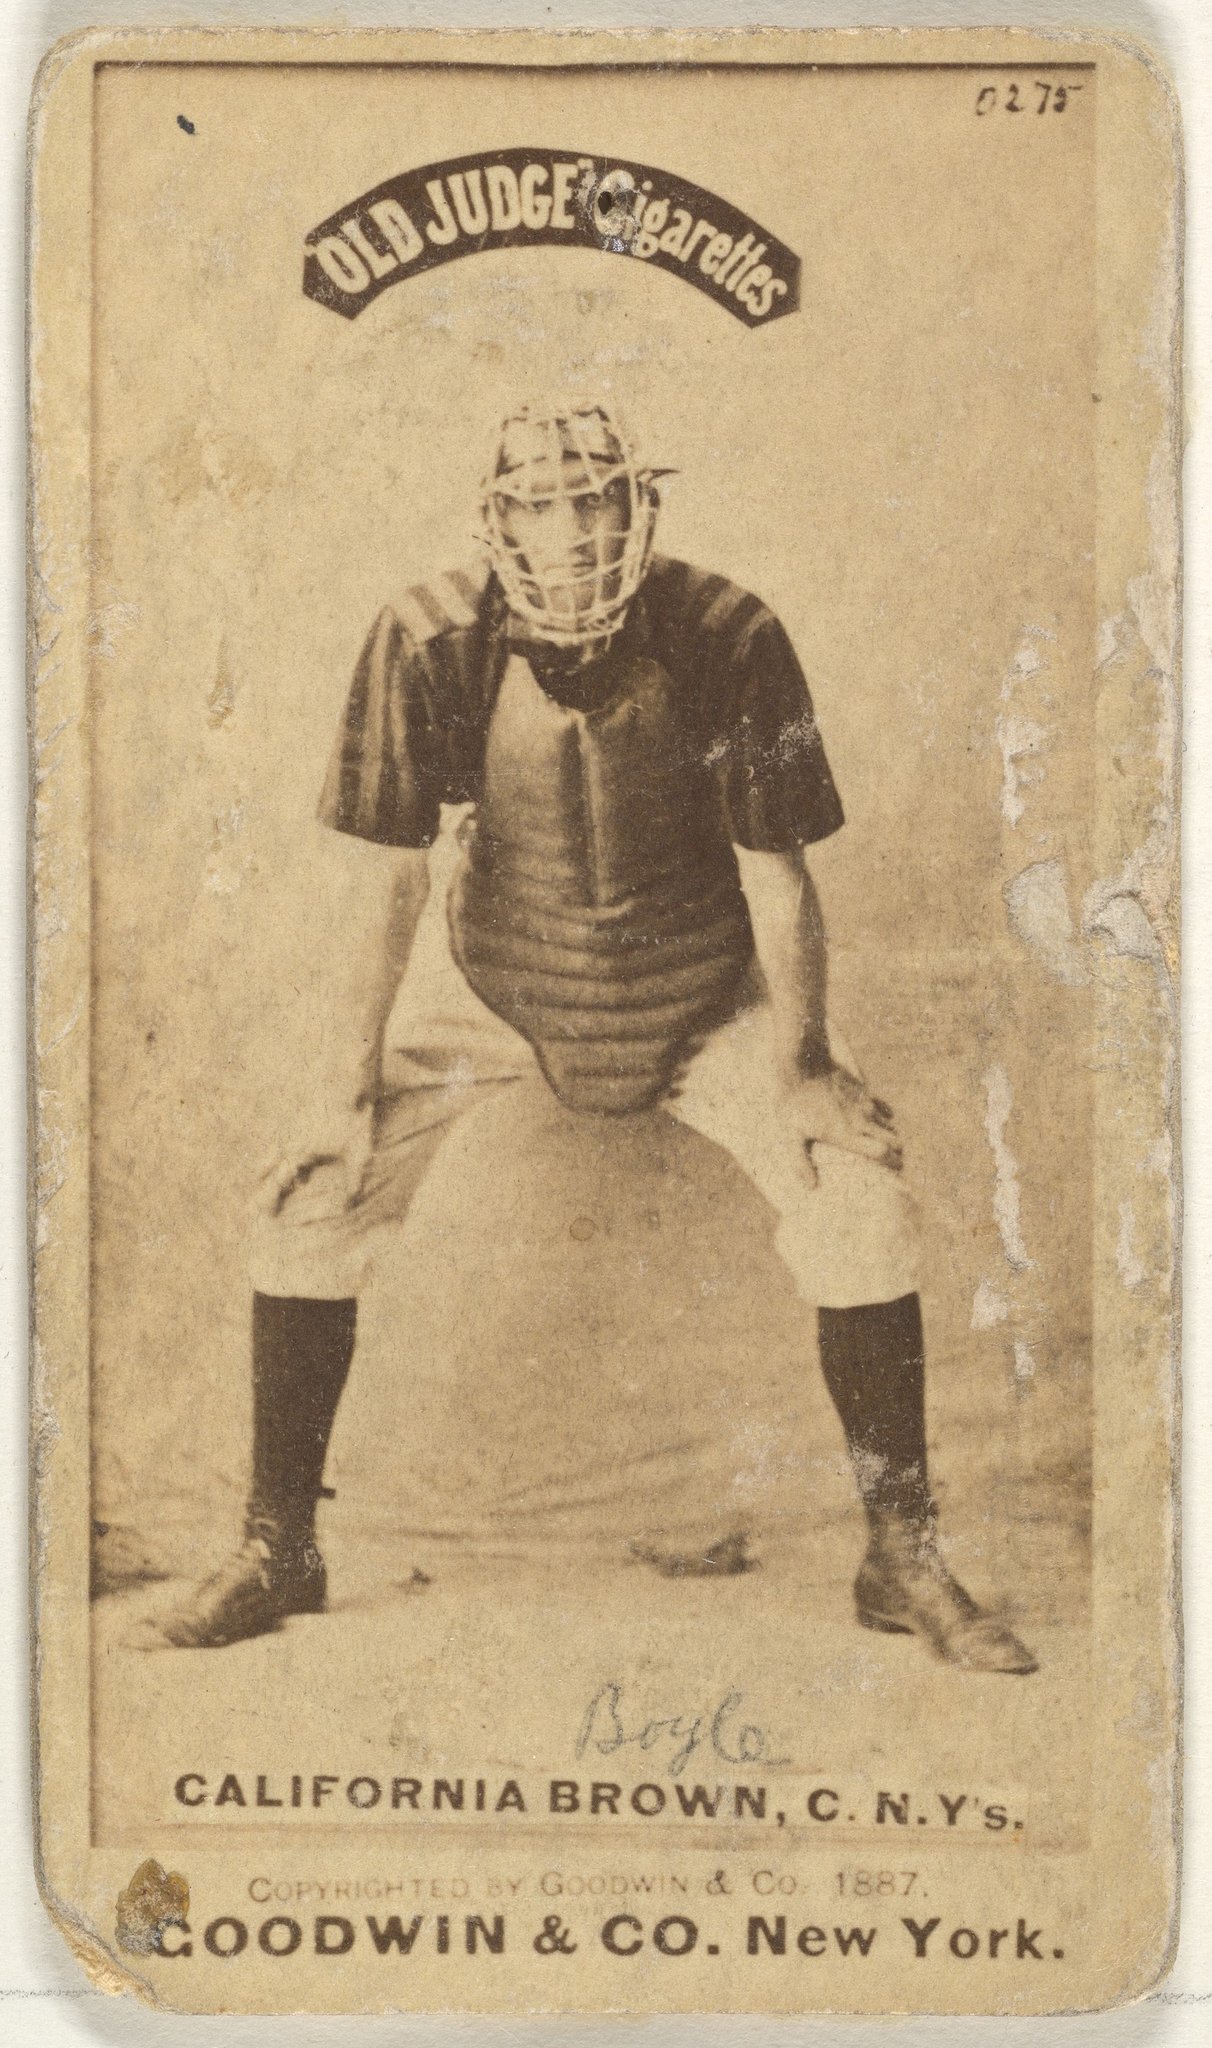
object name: baseball card, photograph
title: William "California" Brown, Catcher, New York, from the Old Judge series (N172) for Old Judge Cigarettes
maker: goodwin & company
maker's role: publisher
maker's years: 1850-1950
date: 1887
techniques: albumen silver print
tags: men,portraits,baseball,athletes